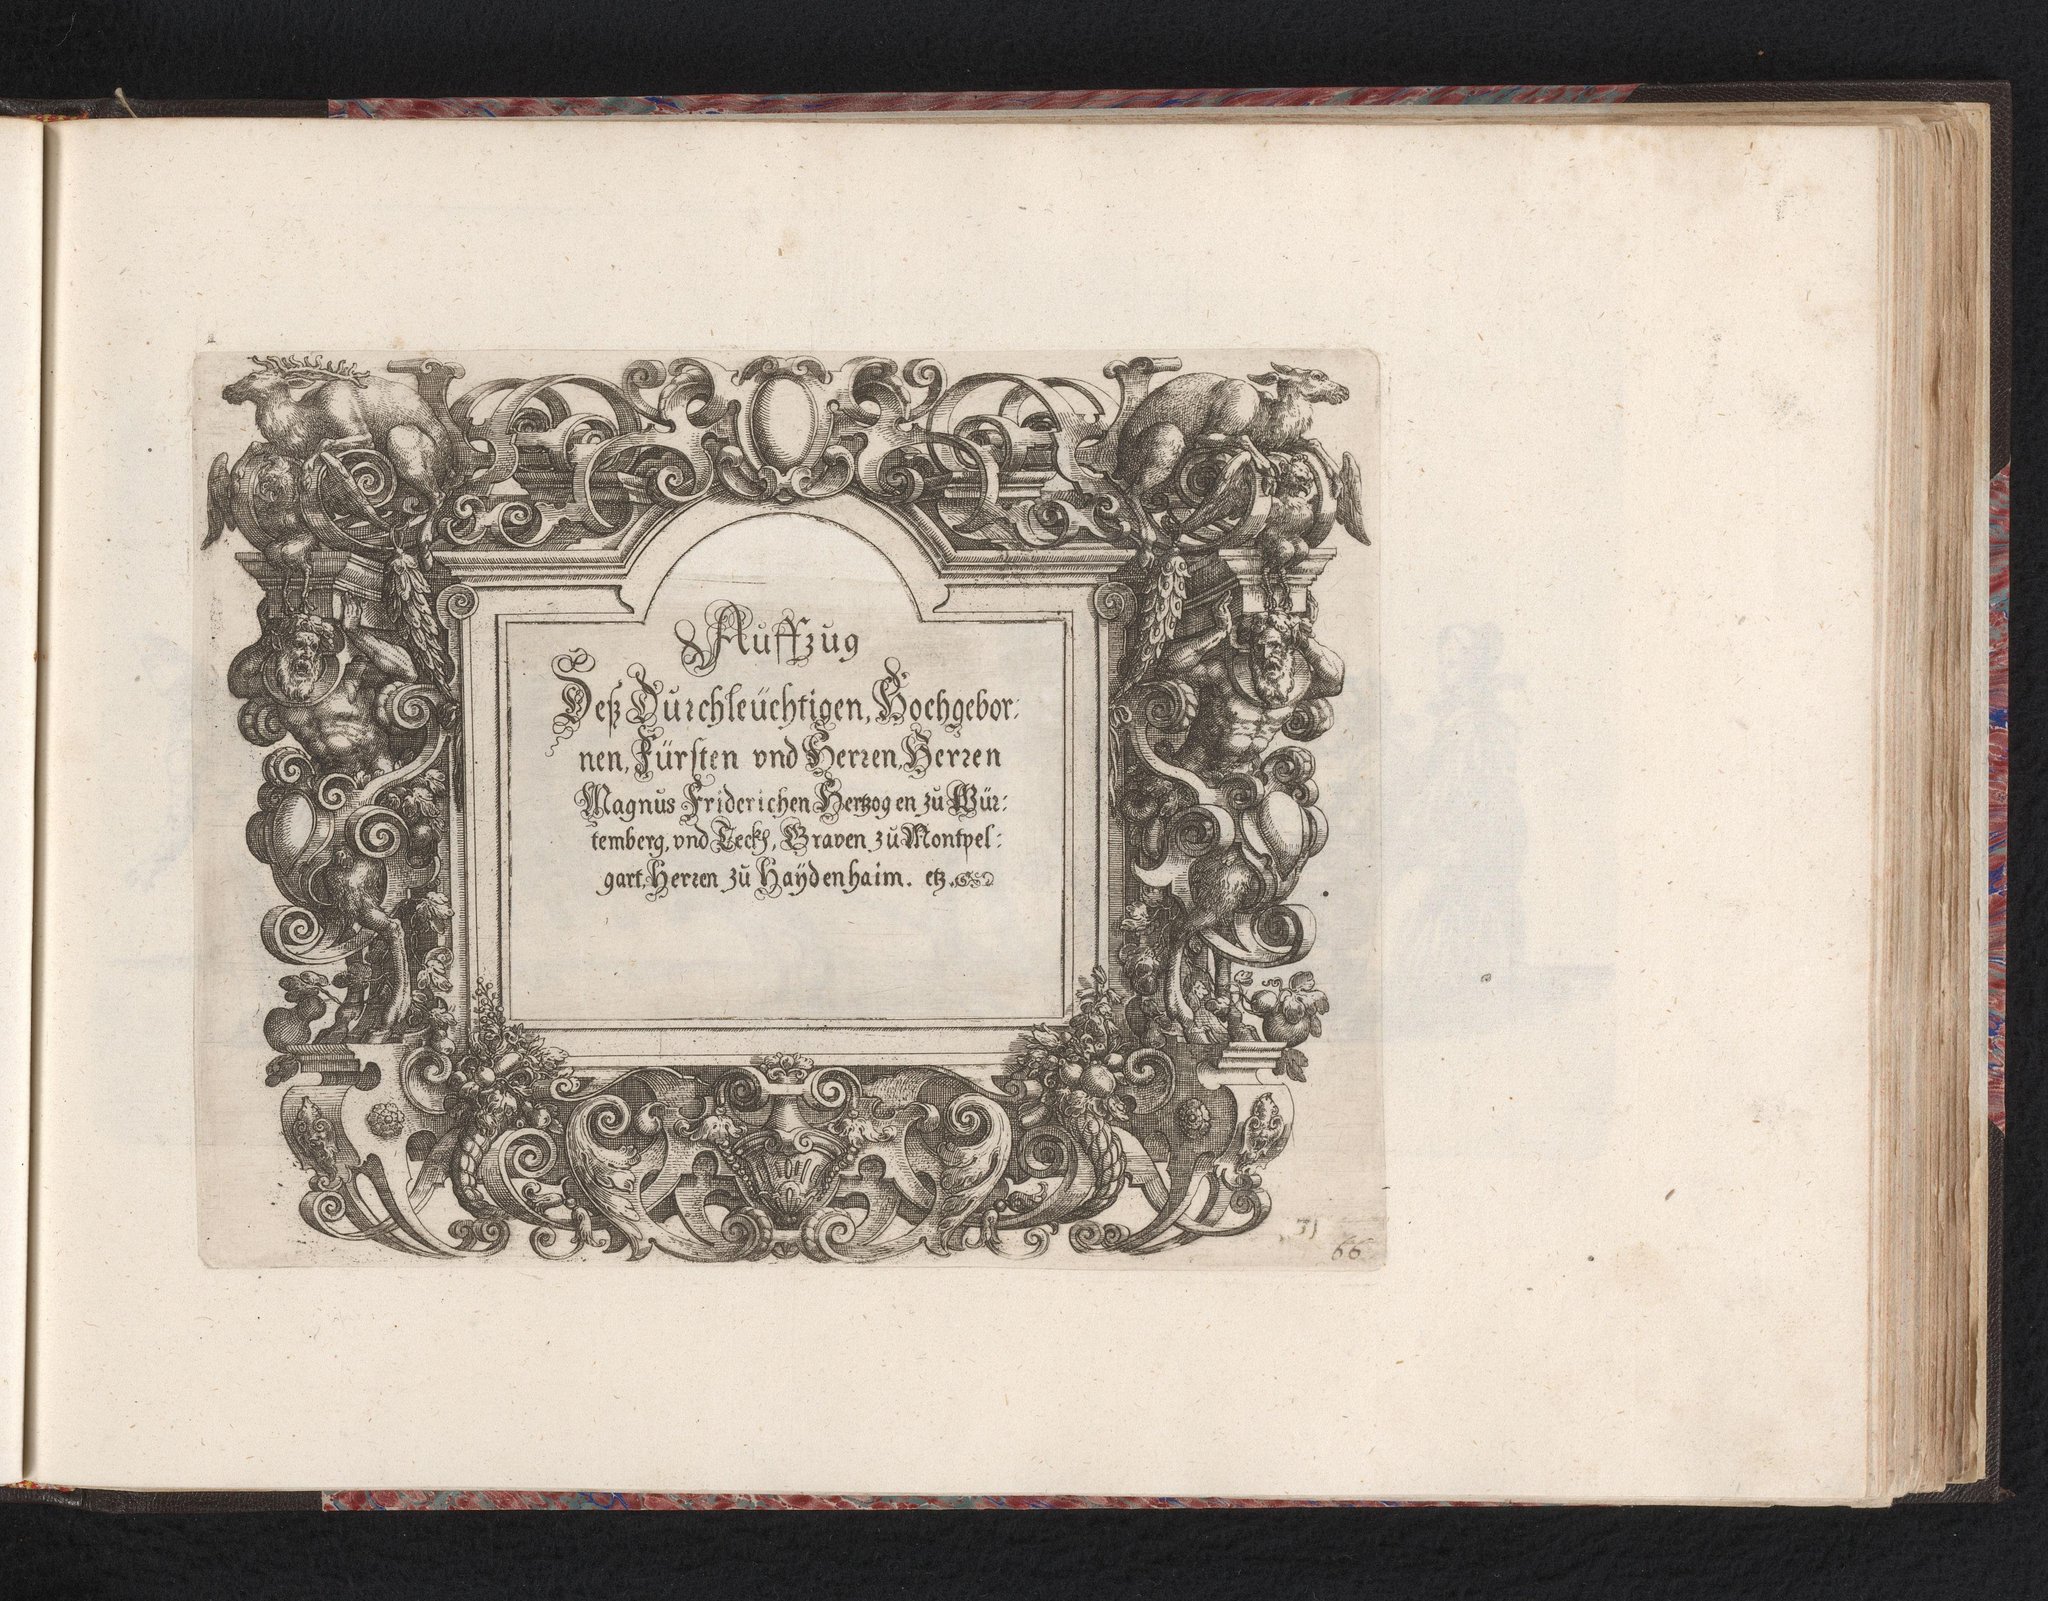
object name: album leaf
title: Aigentliche wahrhaffte Delineation unnd Abbildung aller fürstlichen Auffzüg und Rütterspilen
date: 1618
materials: paper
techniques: etching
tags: performance in the open air (pleasure fair), horses (circus performance)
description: Genummerd: 65. Tekst in het Duits op de borden. Prent maakt deel uit van een album.